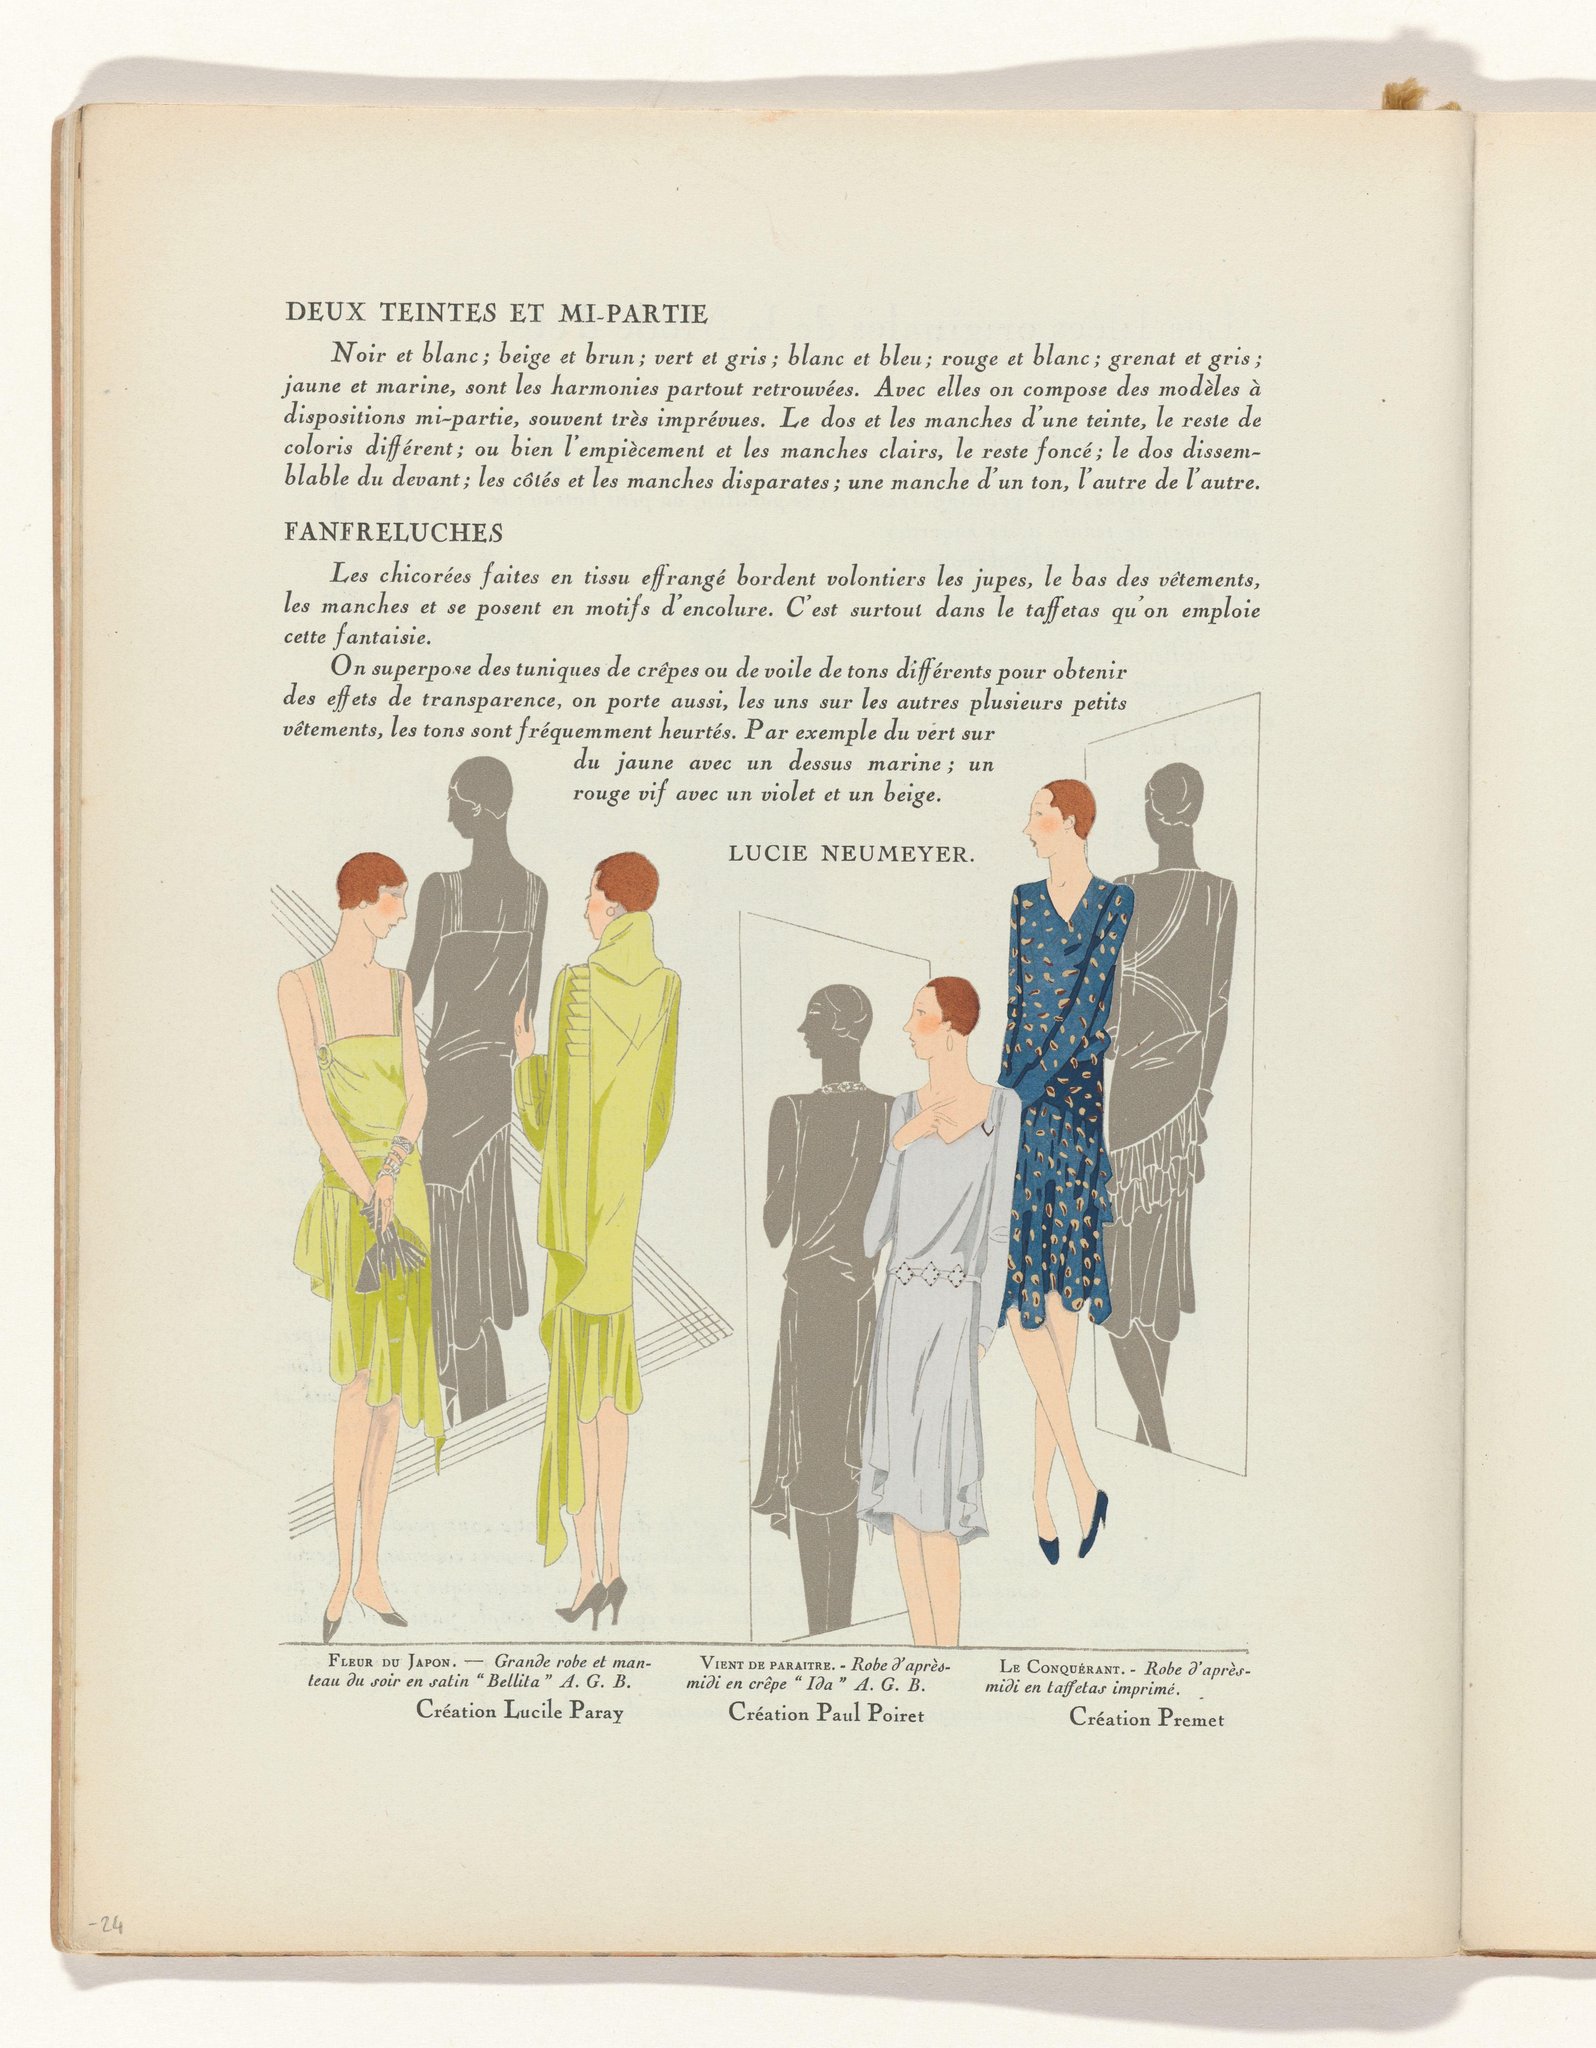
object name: magazine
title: Art - Goût - Beauté, Feuillets de l' élégance féminine, Mai 1929, No. 105, 9e Année, p. 25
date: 1929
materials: paper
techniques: printing, lithograph, photography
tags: dress, gown: evening dress (+ women's clothes), dress, gown (afternoon dress) (+ women's clothes), fashion plates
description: Links twee avondjaponnen van Lucille Paray; rechts middagjaponnen van Paul Poiret en Premet. Pagina uit het modetijdschrift Art-Goût-Beauté (1920-1933).